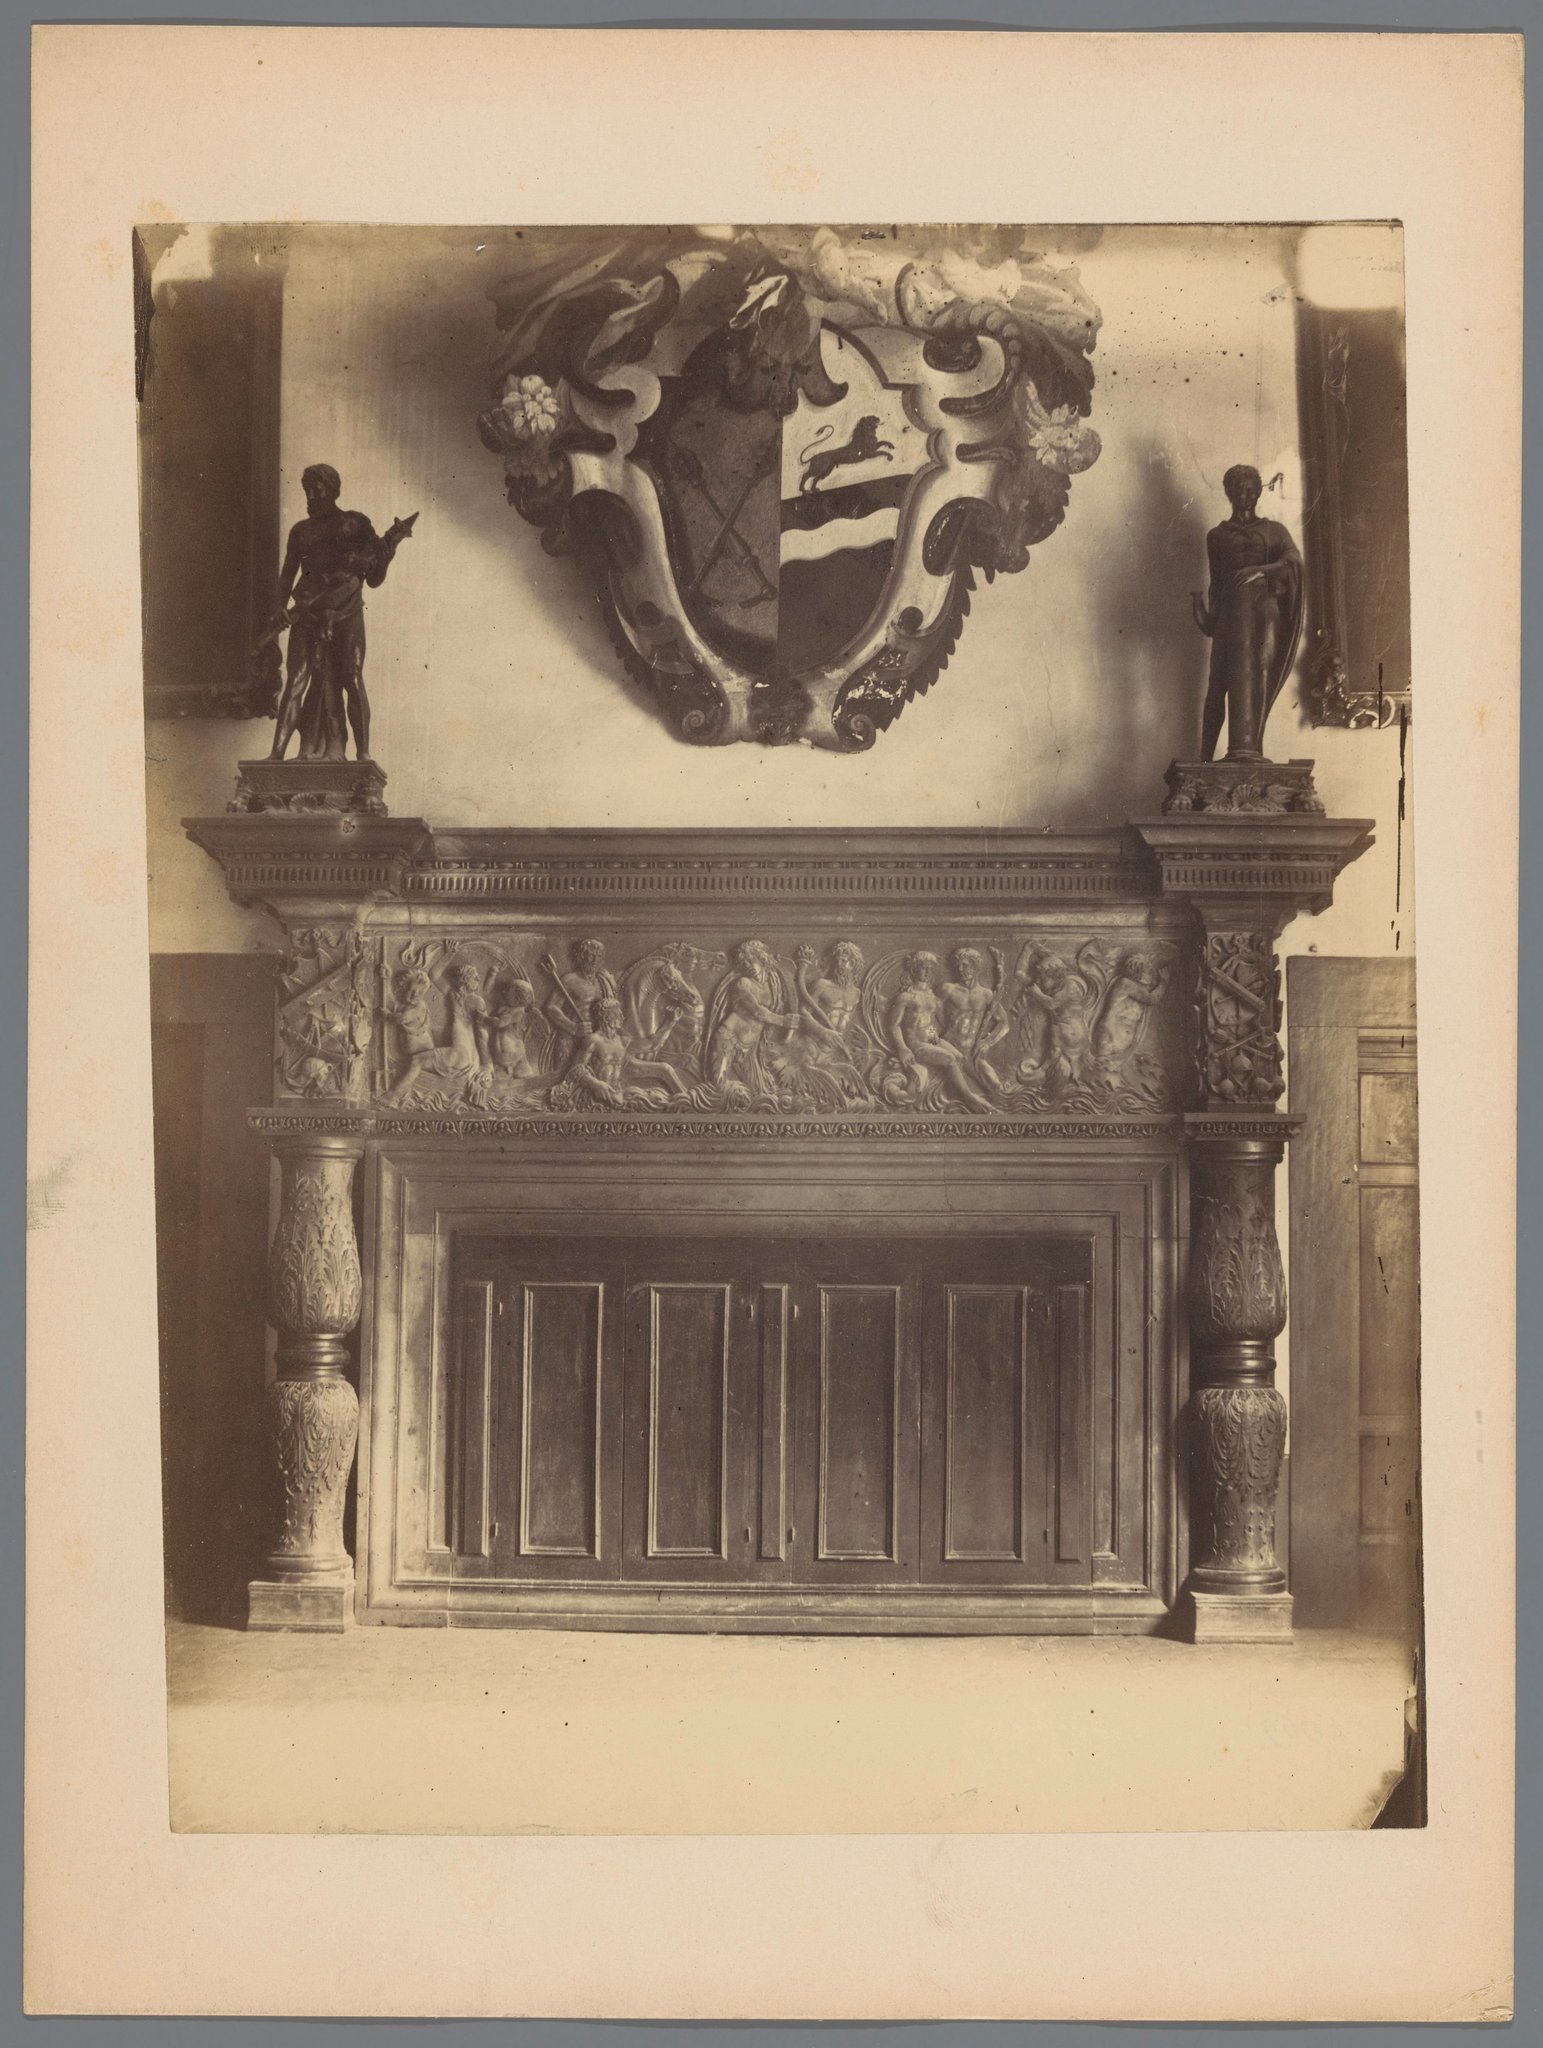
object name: photograph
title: Interieur met een wapenschild en een schouw met Herakles en (vermoedelijk) de Kracht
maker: Anonymous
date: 1875-1900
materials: cardboard, photographic support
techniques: albumen print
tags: fortitude, 'fortitudo' ~ one of the four cardinal virtues, coat of arms (symbol of sovereignty), (story of) hercules (heracles), open hearth, fire-place, other nereids (or sea-nymphs)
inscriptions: collector's mark: Lugt 3937